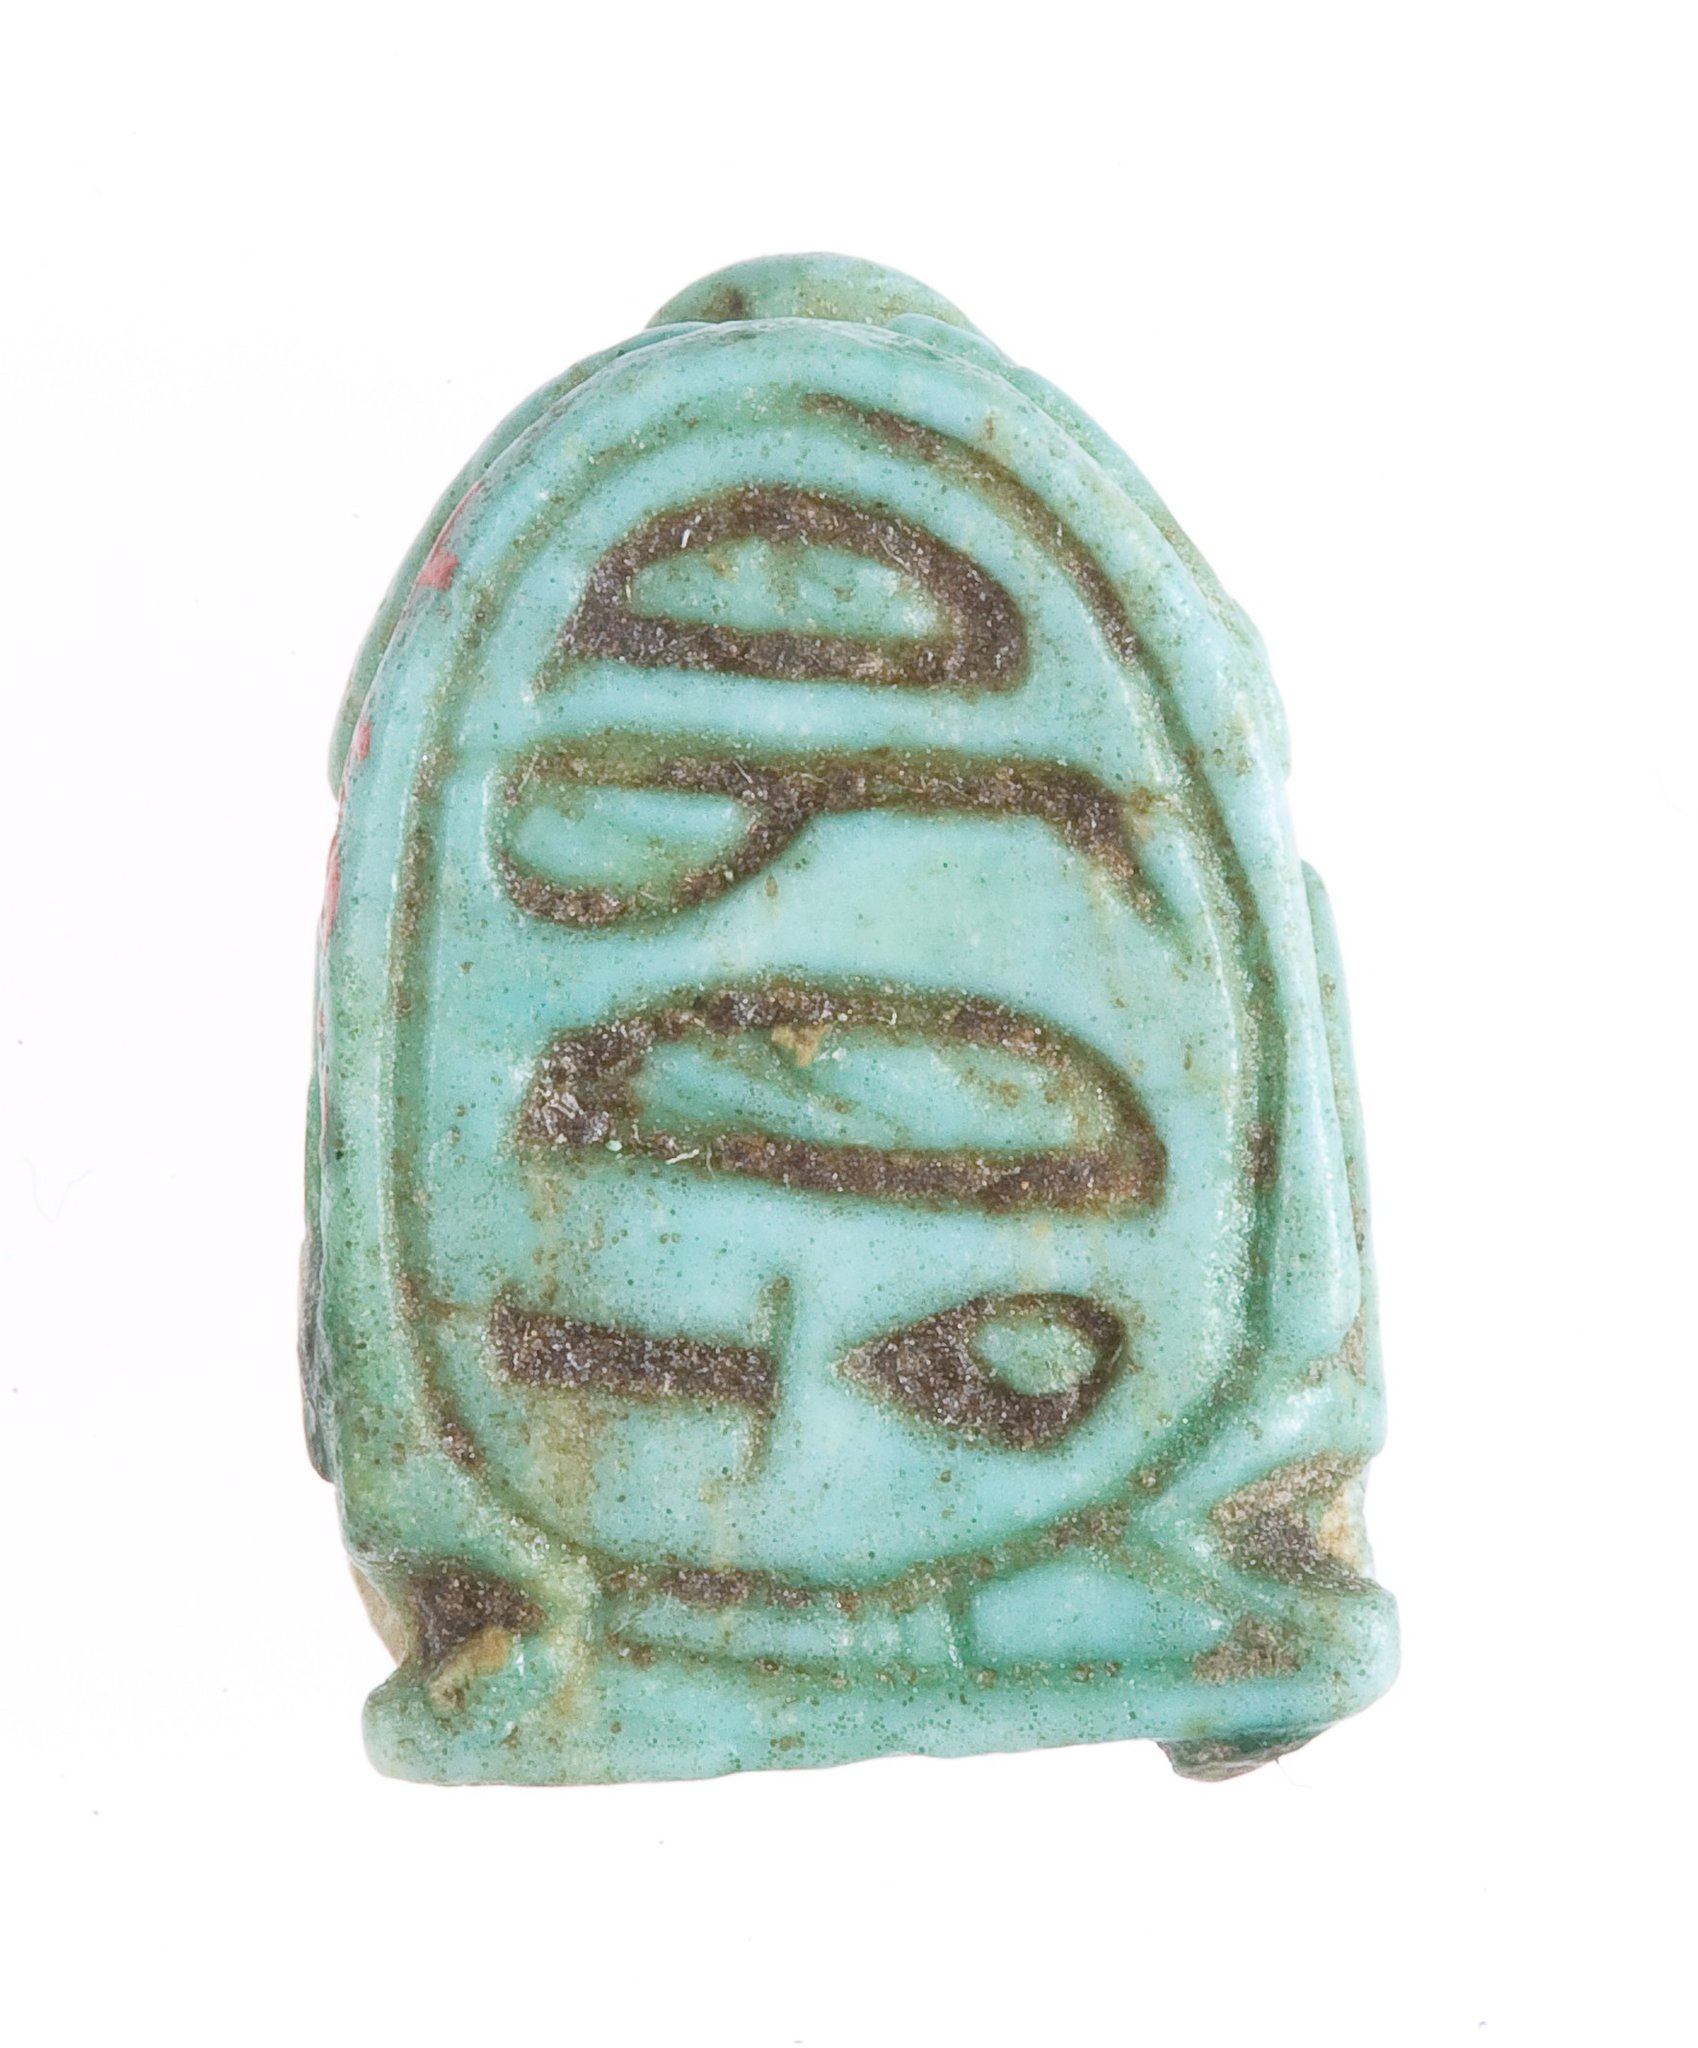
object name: amulet, fly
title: Design Amulet in the Shape of a Fly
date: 1550-1425 BCE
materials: stone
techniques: glazing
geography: egypt